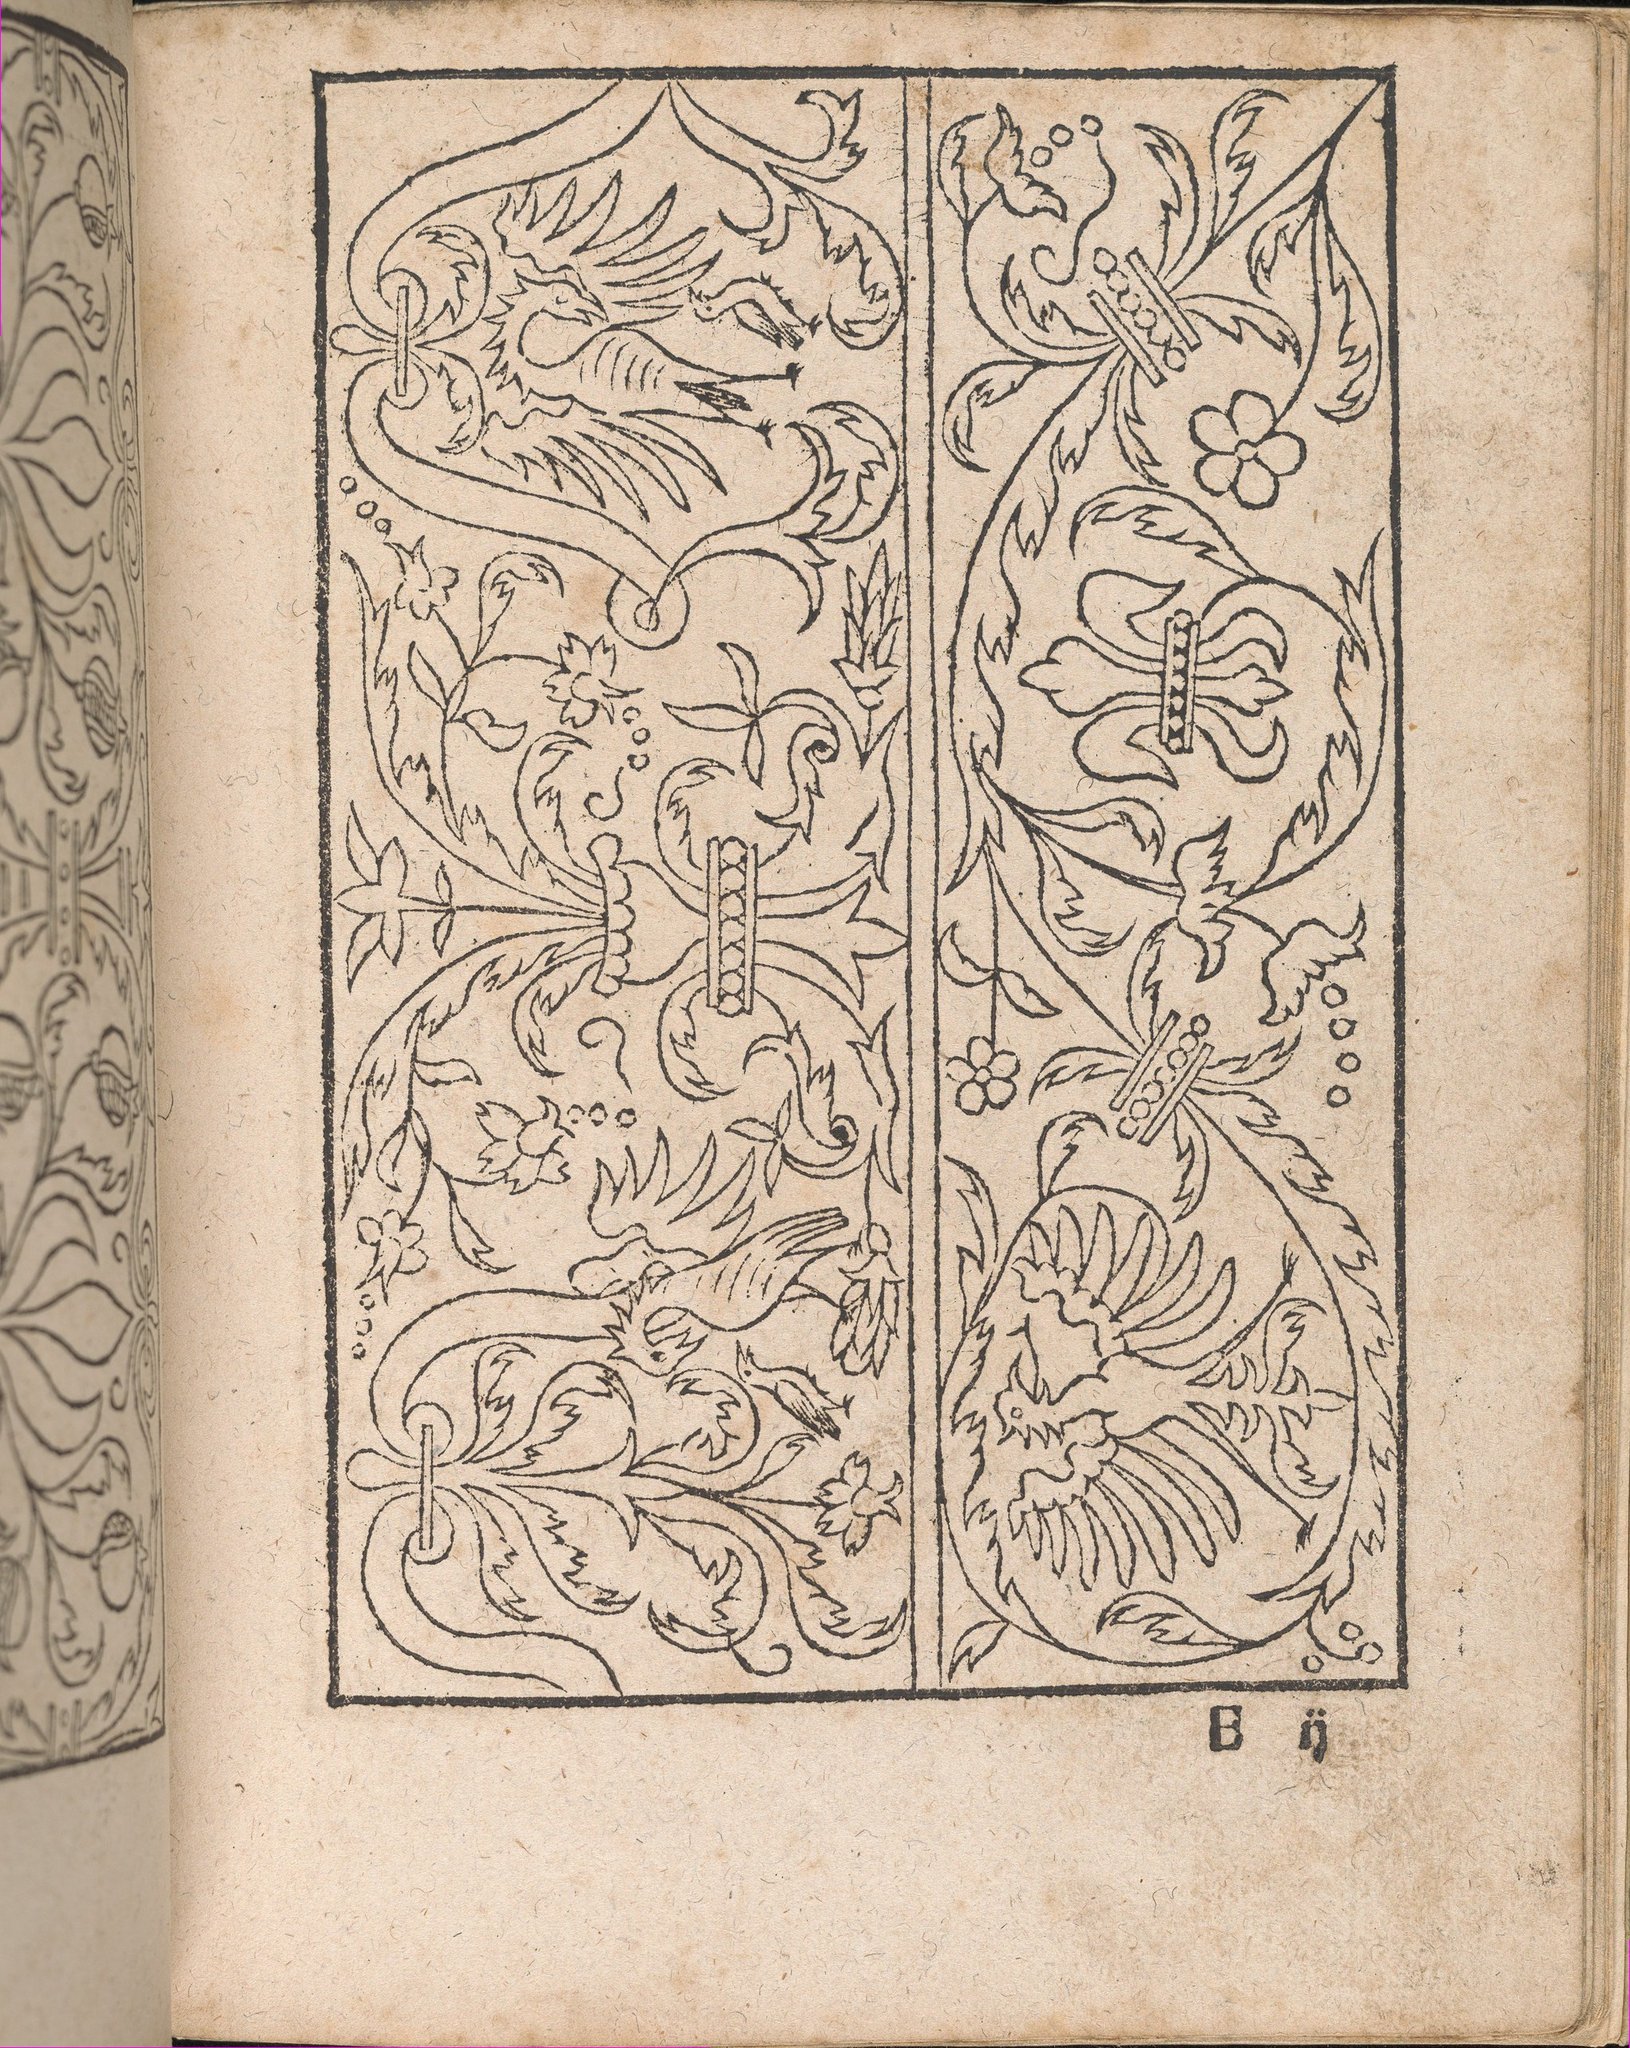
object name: book print ornament architecture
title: New Modelbüch allen Nägerin u. Sydenstickern (Page 18r)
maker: hans hoffman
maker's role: designer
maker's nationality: german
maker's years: 1556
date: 1556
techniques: woodcut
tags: birds,flowers